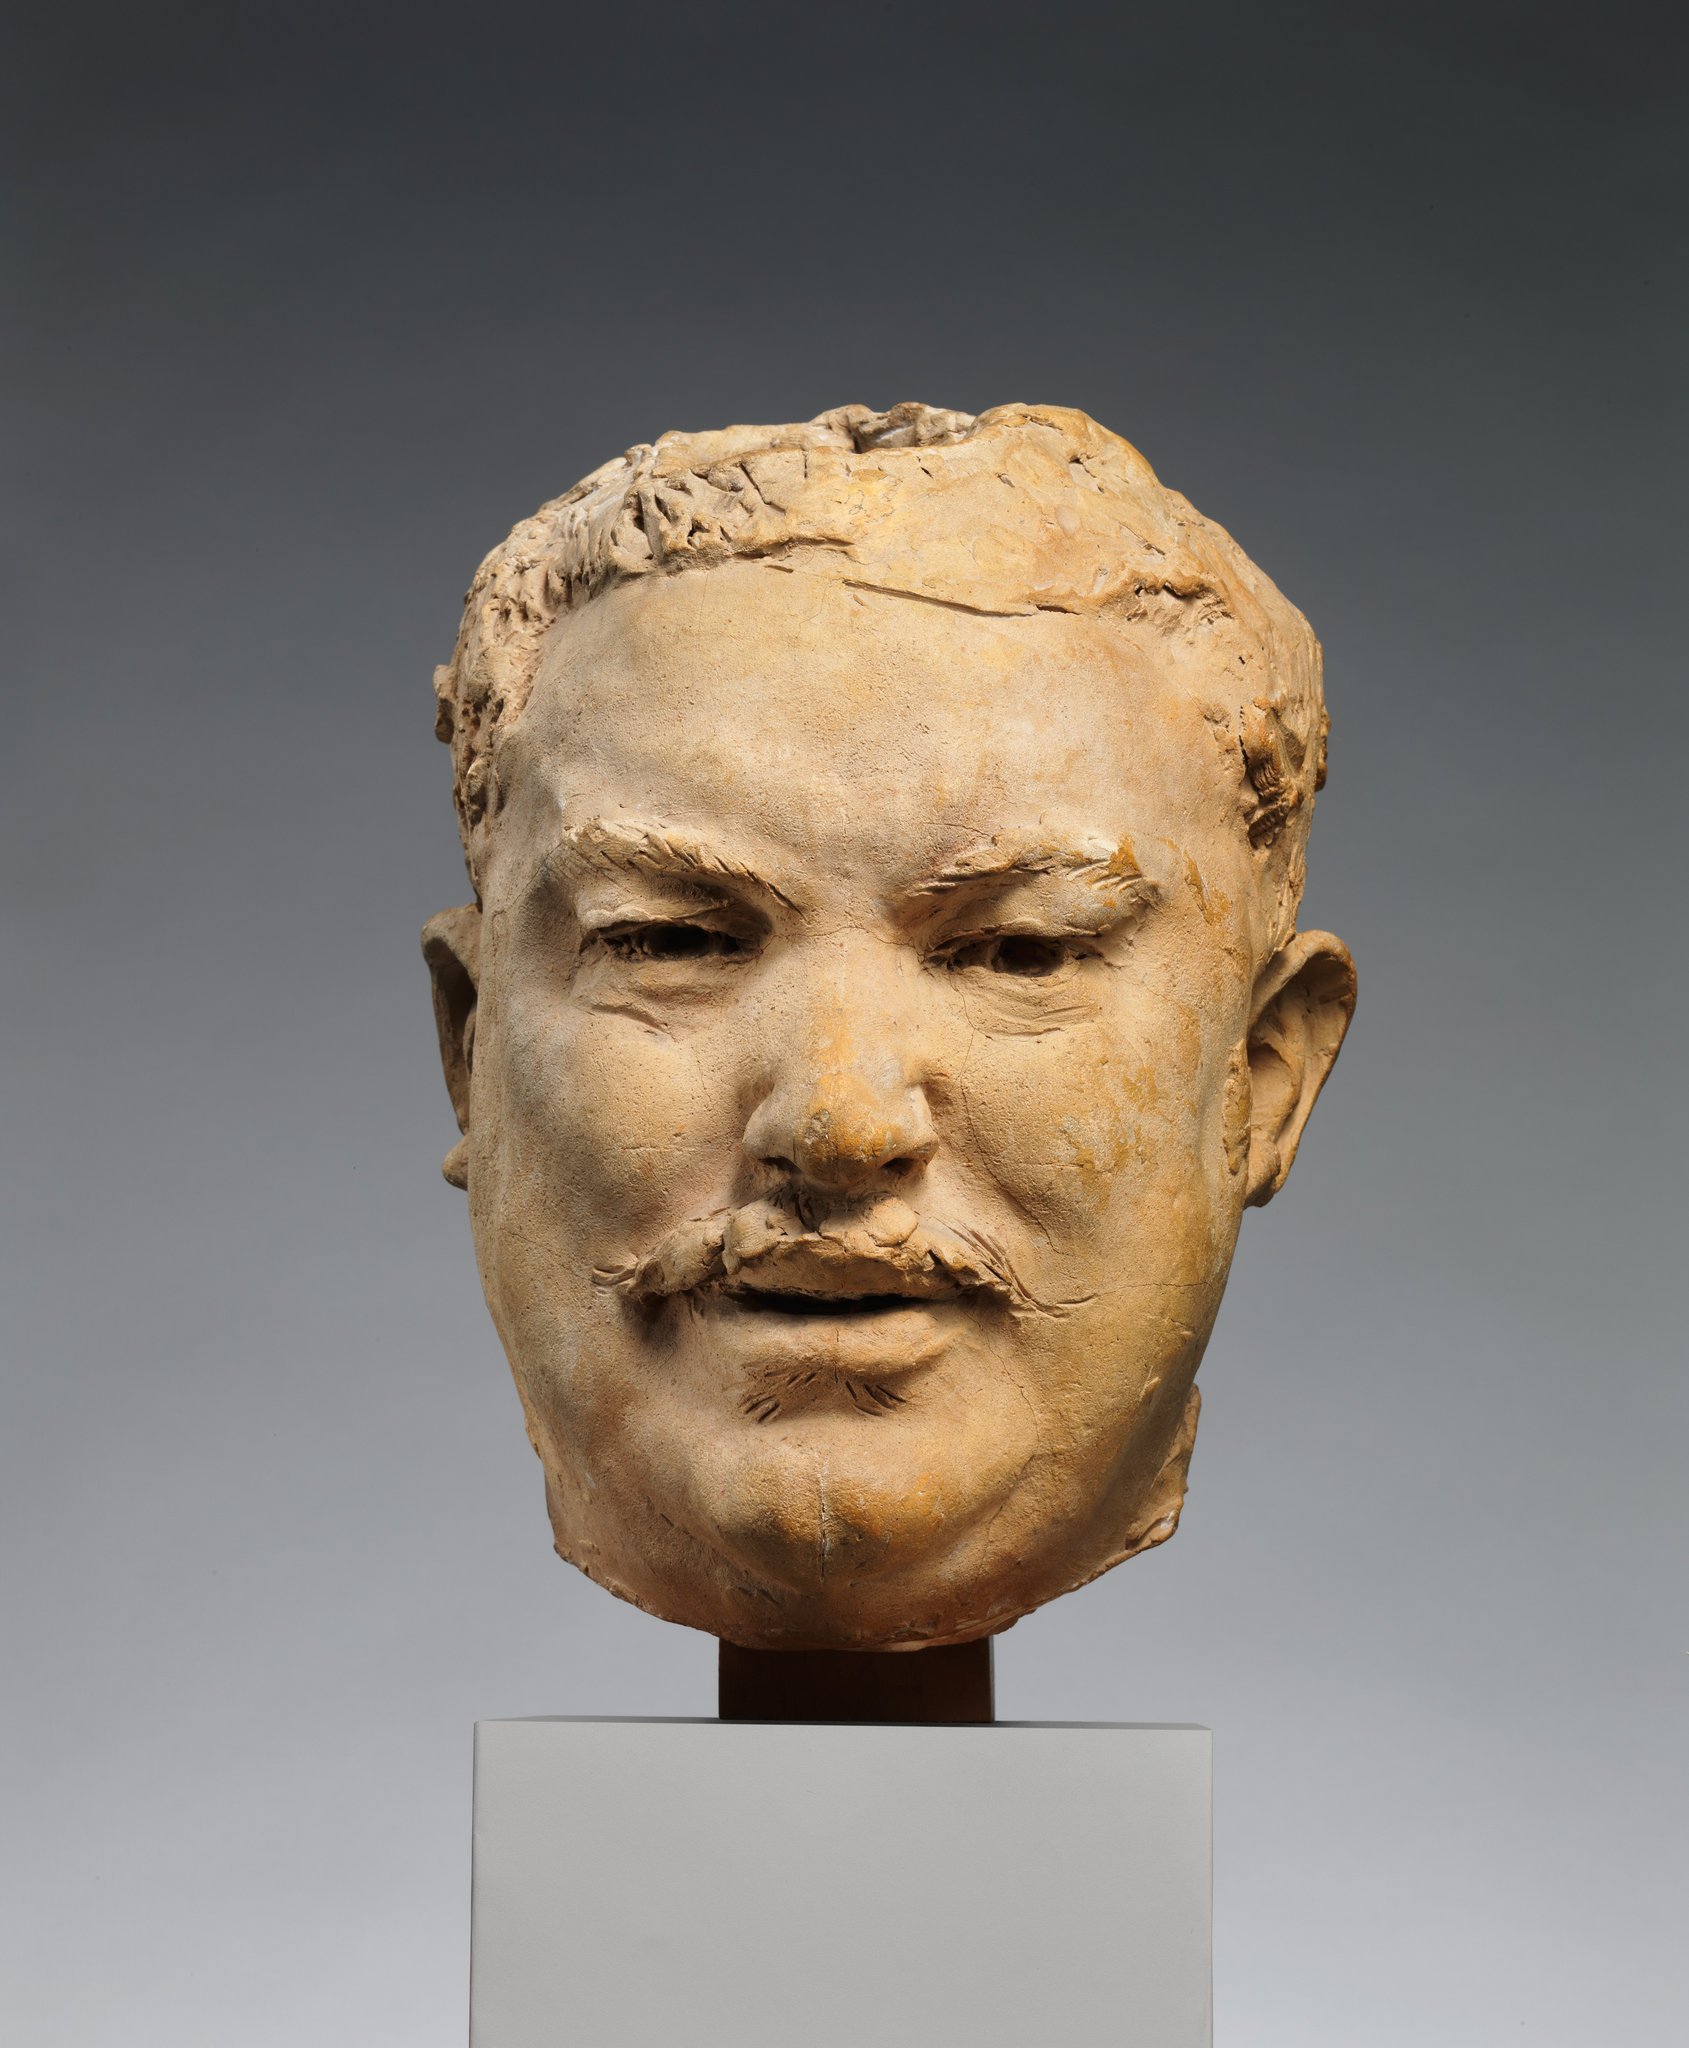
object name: bust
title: Honoré de Balzac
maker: auguste rodin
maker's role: artist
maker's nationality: french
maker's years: 1840-1917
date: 1891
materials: terracotta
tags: men,portraits,authors